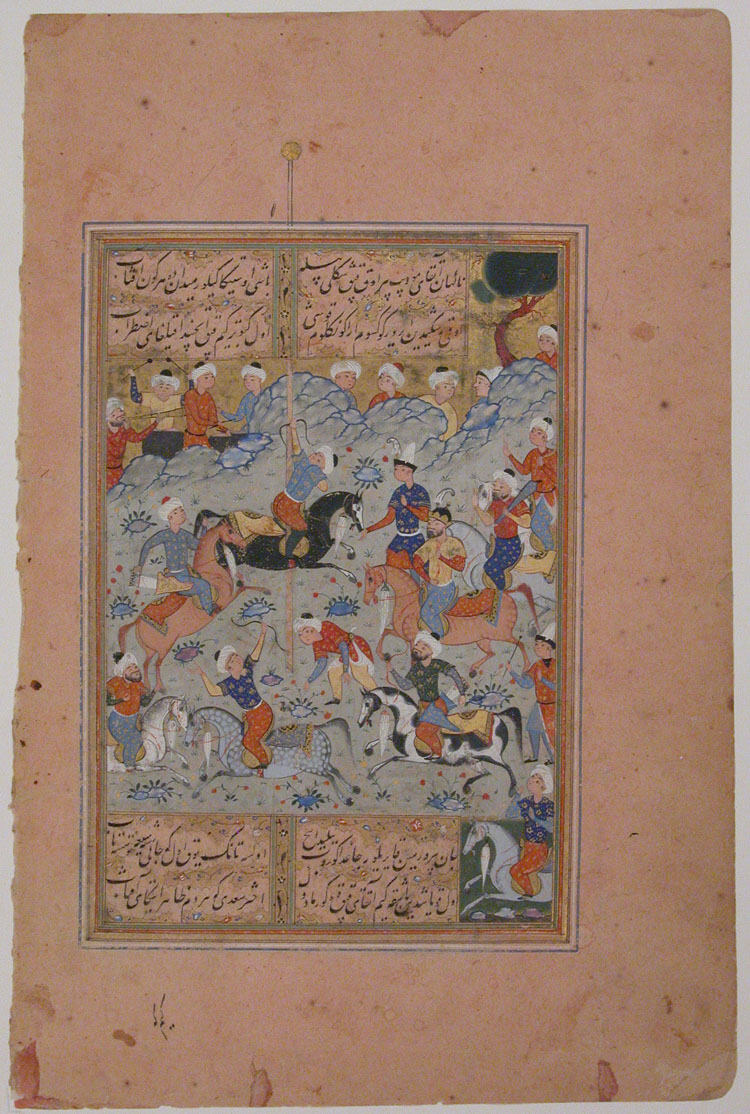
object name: folio from an illustrated manuscript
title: "A Contest of Skill in Archery on Horseback", Folio from a Divan (Collected Works) of Mir 'Ali Shir Nava'i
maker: mir 'ali shir nava'i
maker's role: author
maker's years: 1416-1476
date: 1580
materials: gold, ink, paper, watercolor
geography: iran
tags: men,horses